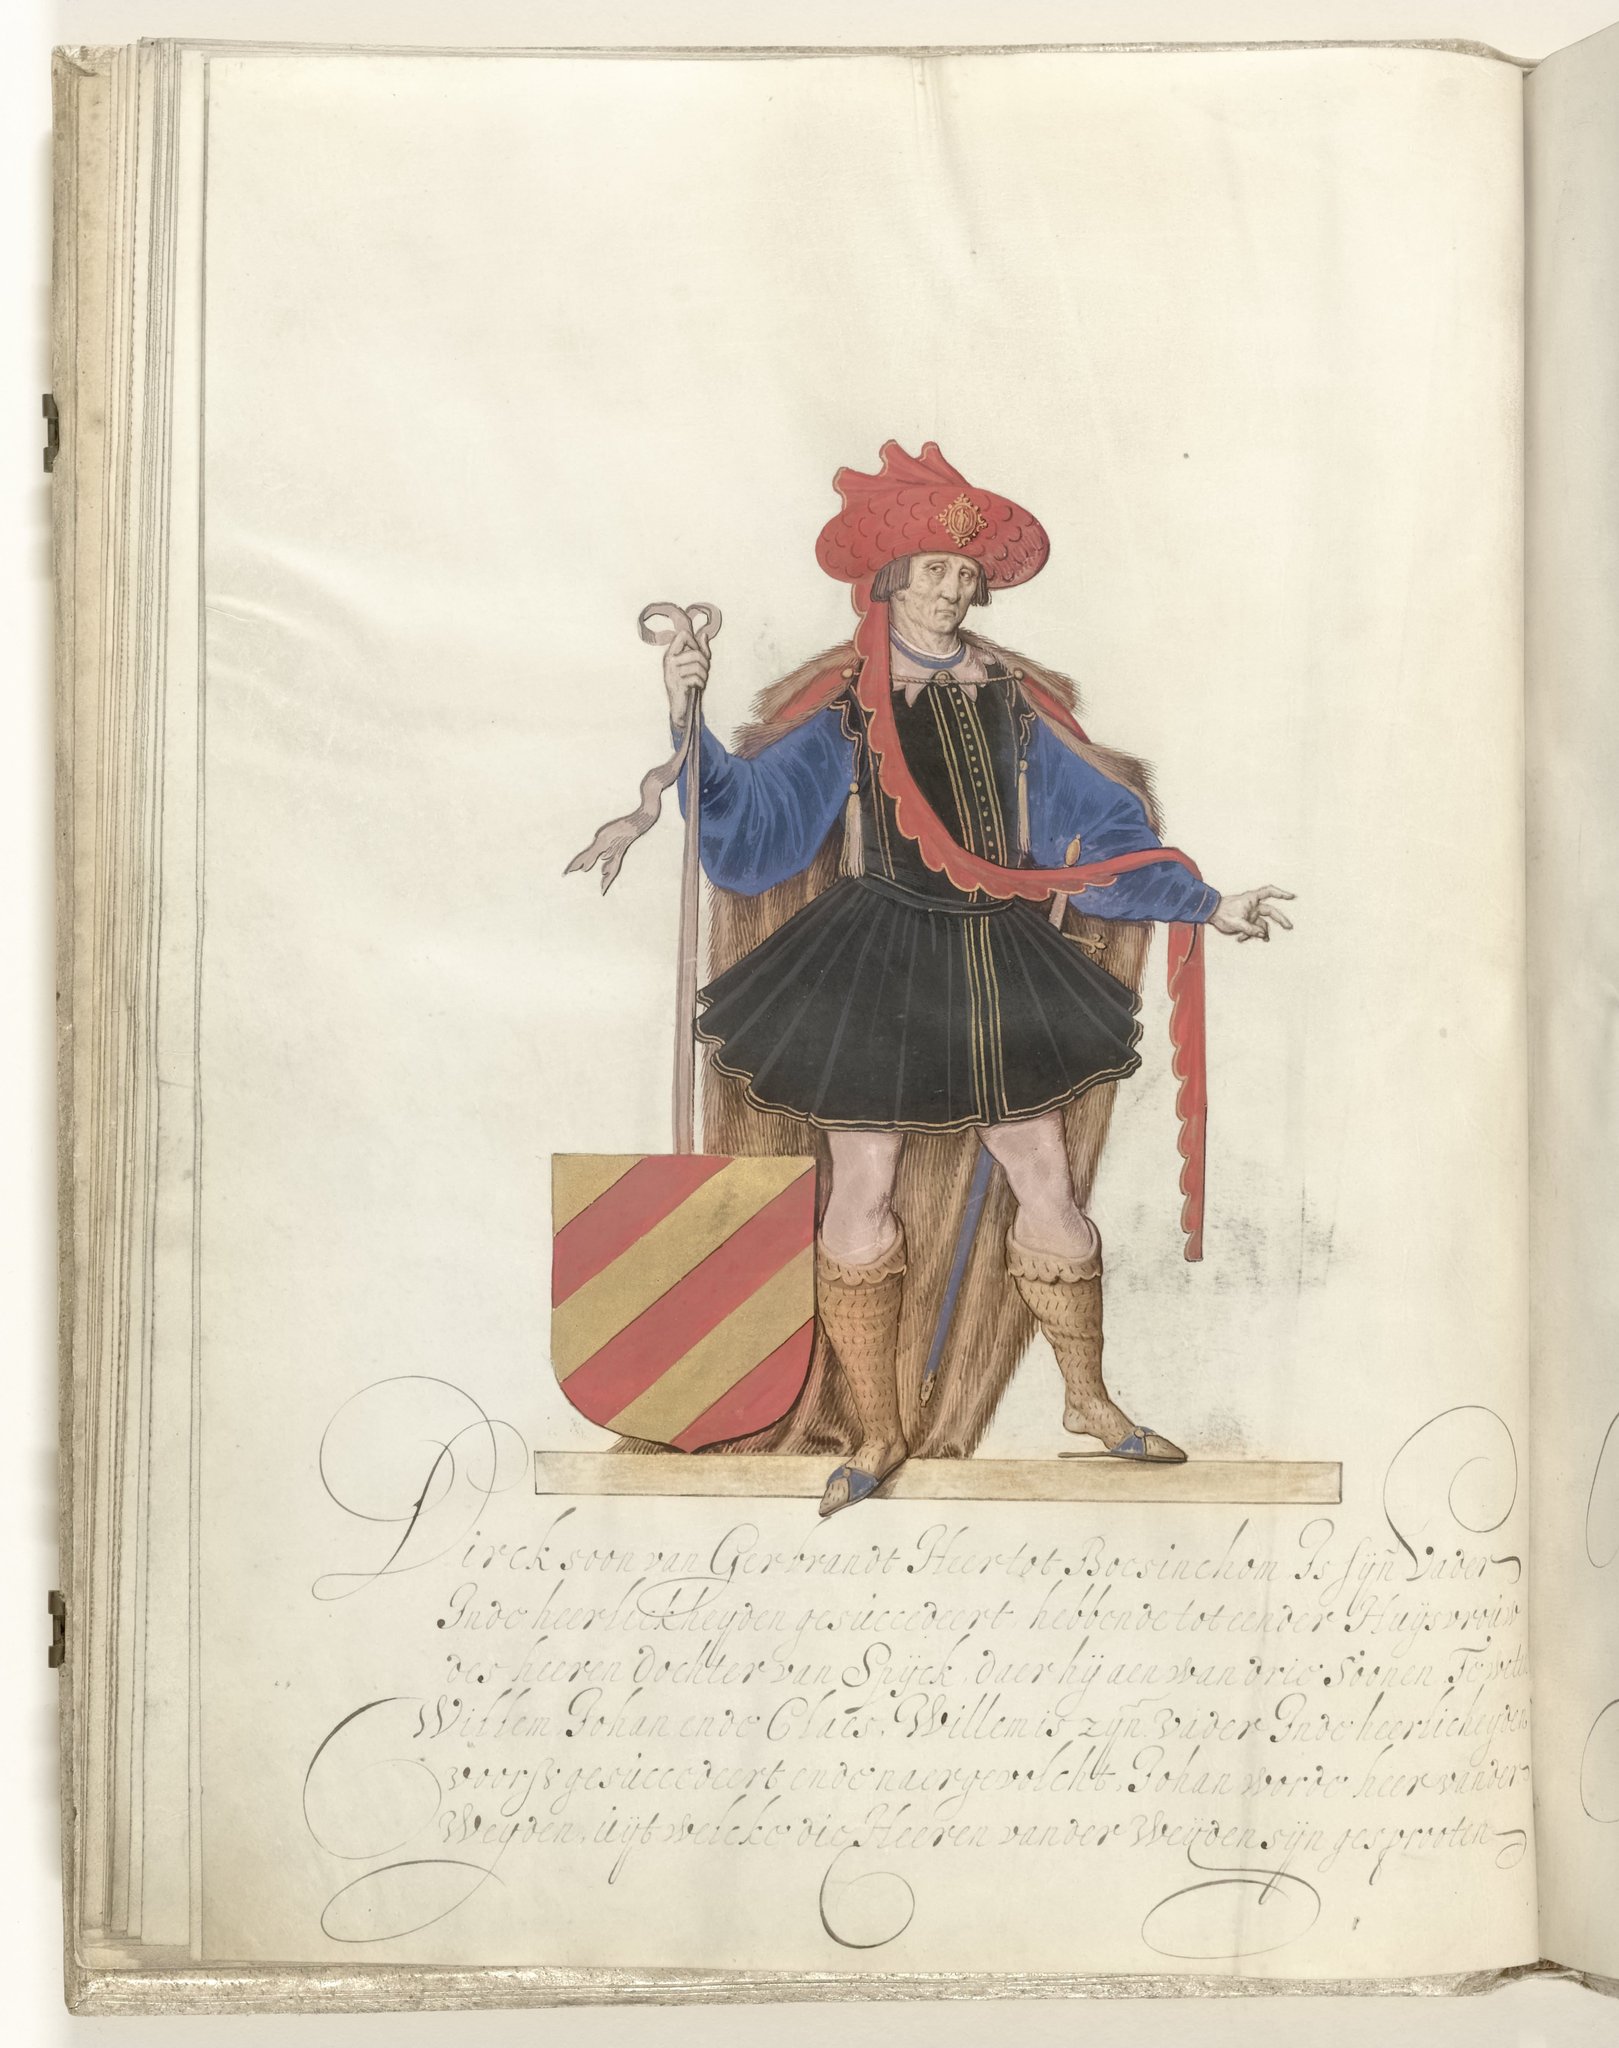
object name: drawing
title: Graaf Dirk van Beusichem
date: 1590-1593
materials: paint, gouache, ink, parchment, watercolor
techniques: writing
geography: northern netherlands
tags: culemborg, heren en graven van, heren van beusichem, dirk graaf van beusichem, culemborg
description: Dirk, graaf van Beusichem (Boesinchem). Staande ten voeten uit, het wapen van Beusichem aan een lint in de rechterhand. Onderdeel van geïllustreerd handschrift met de genealogie van de heren en graven van Culemborg.